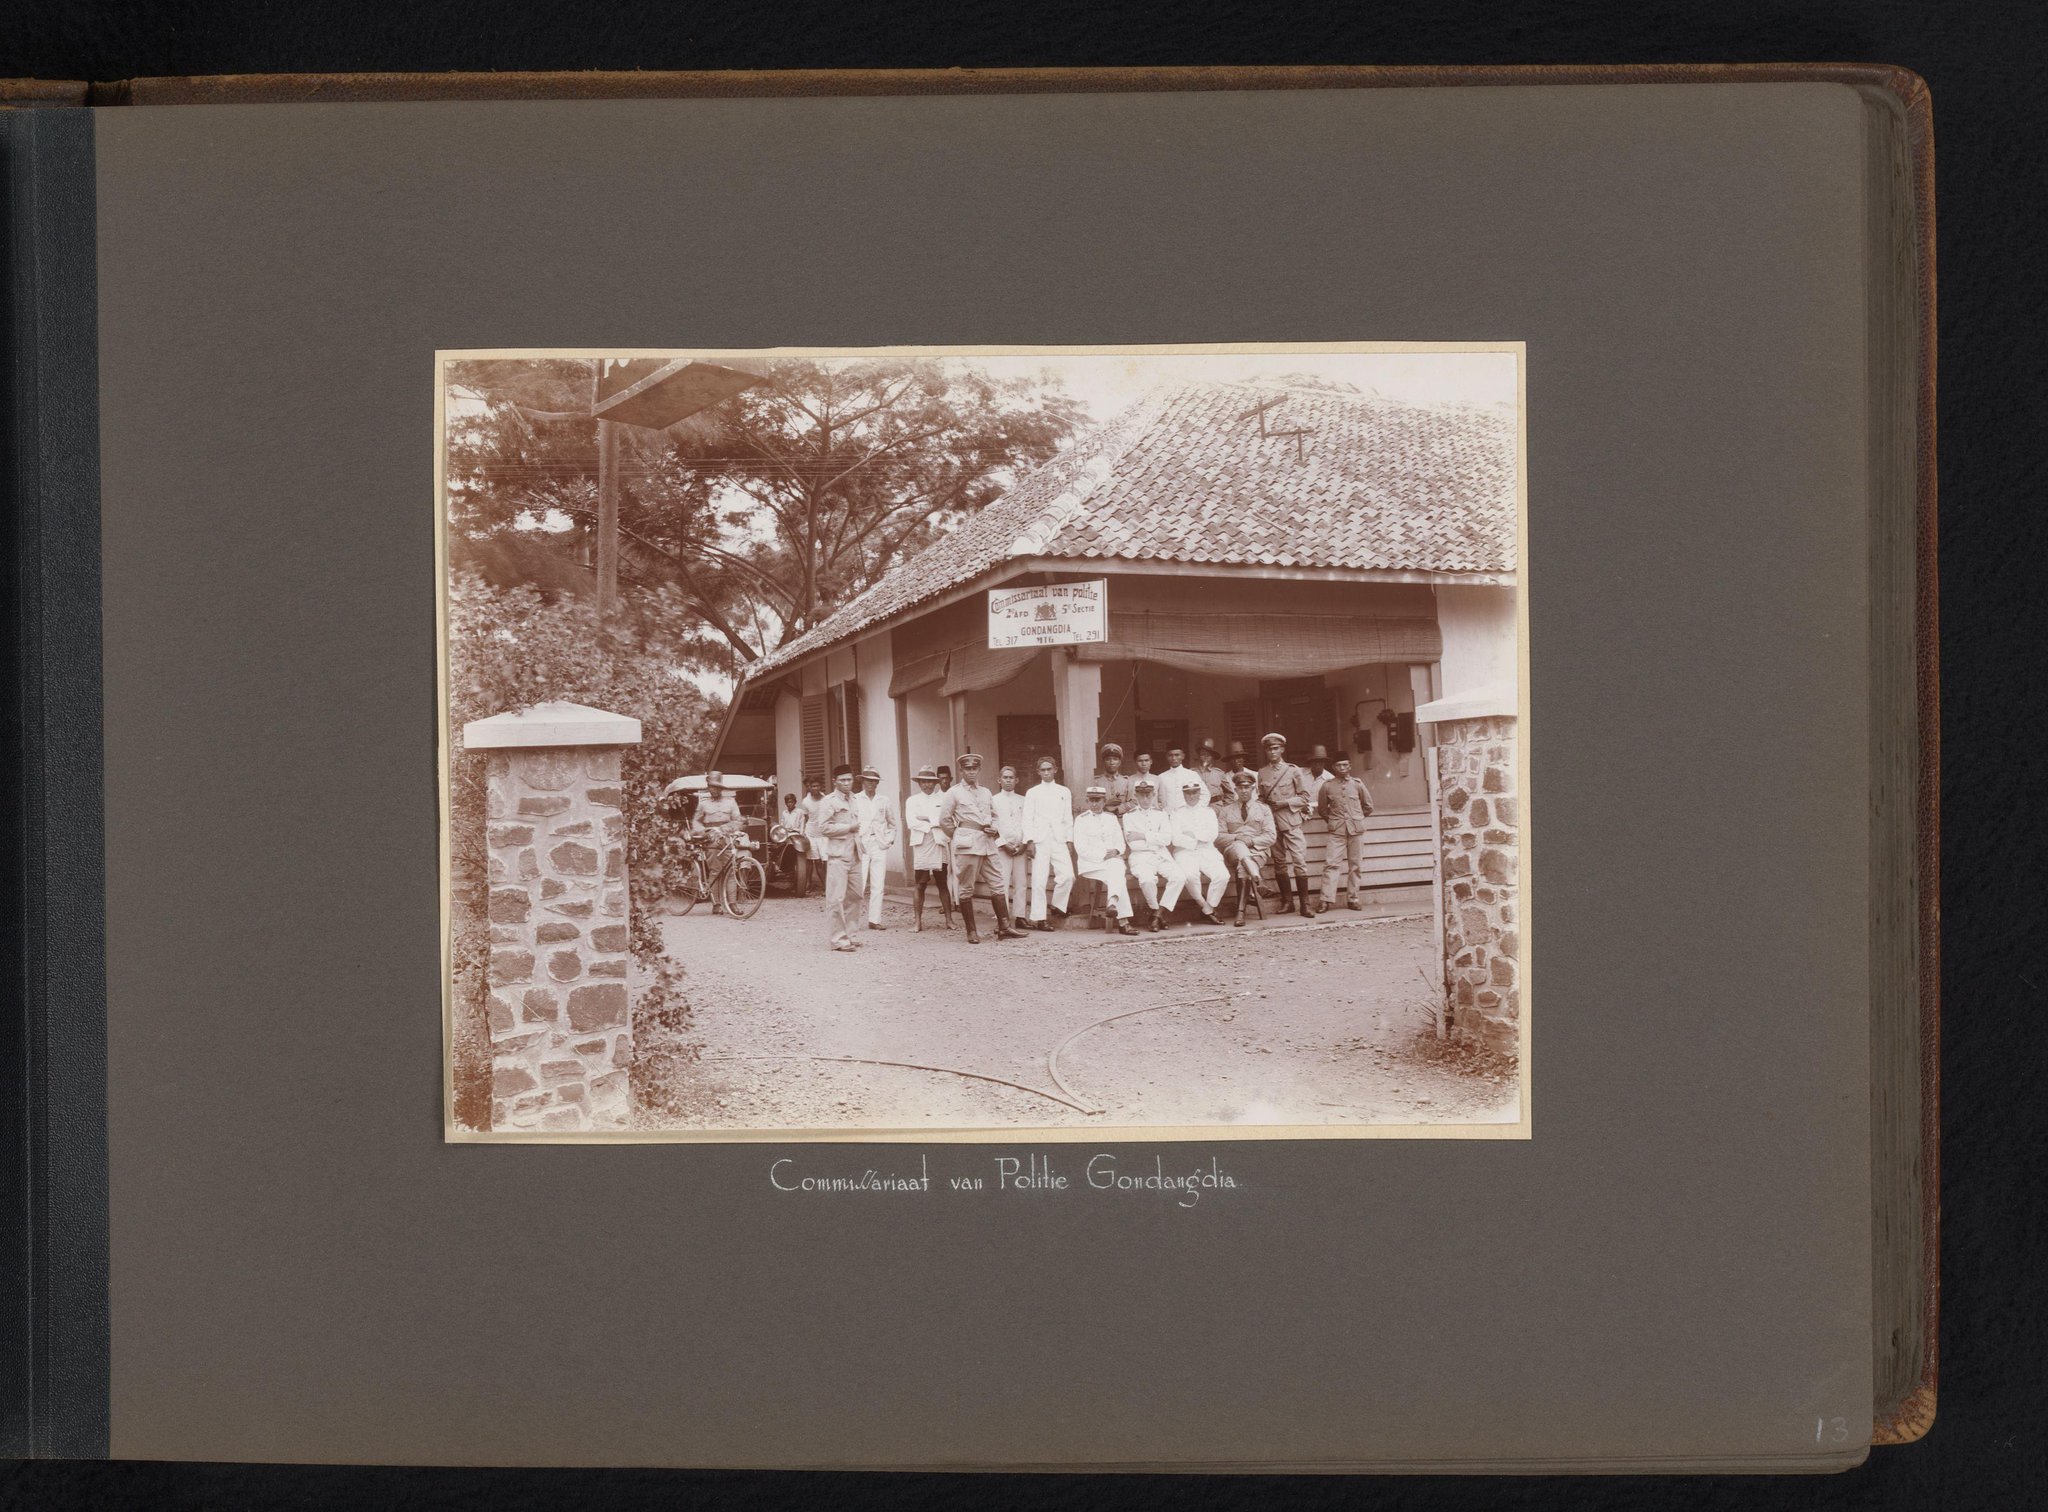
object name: album leaf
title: Commissariaat van Politie Gondangdia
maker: Anonymous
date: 1925-1931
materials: cardboard, photographic support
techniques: collodion silver print, gelatin silver print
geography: batavia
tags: dutch east indies, the, batavia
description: Albumblad met één foto: Commissariaat van Politie Gondangdia, 2e afdeling, 5e sectie te Batavia. Staf poseert voor het gebouw. Onderdeel van het fotoalbum aangeboden aan S. Koster door de Vereeniging van Hoogere Politie Ambtenaren in Nederlandsch-Indië in 1931.